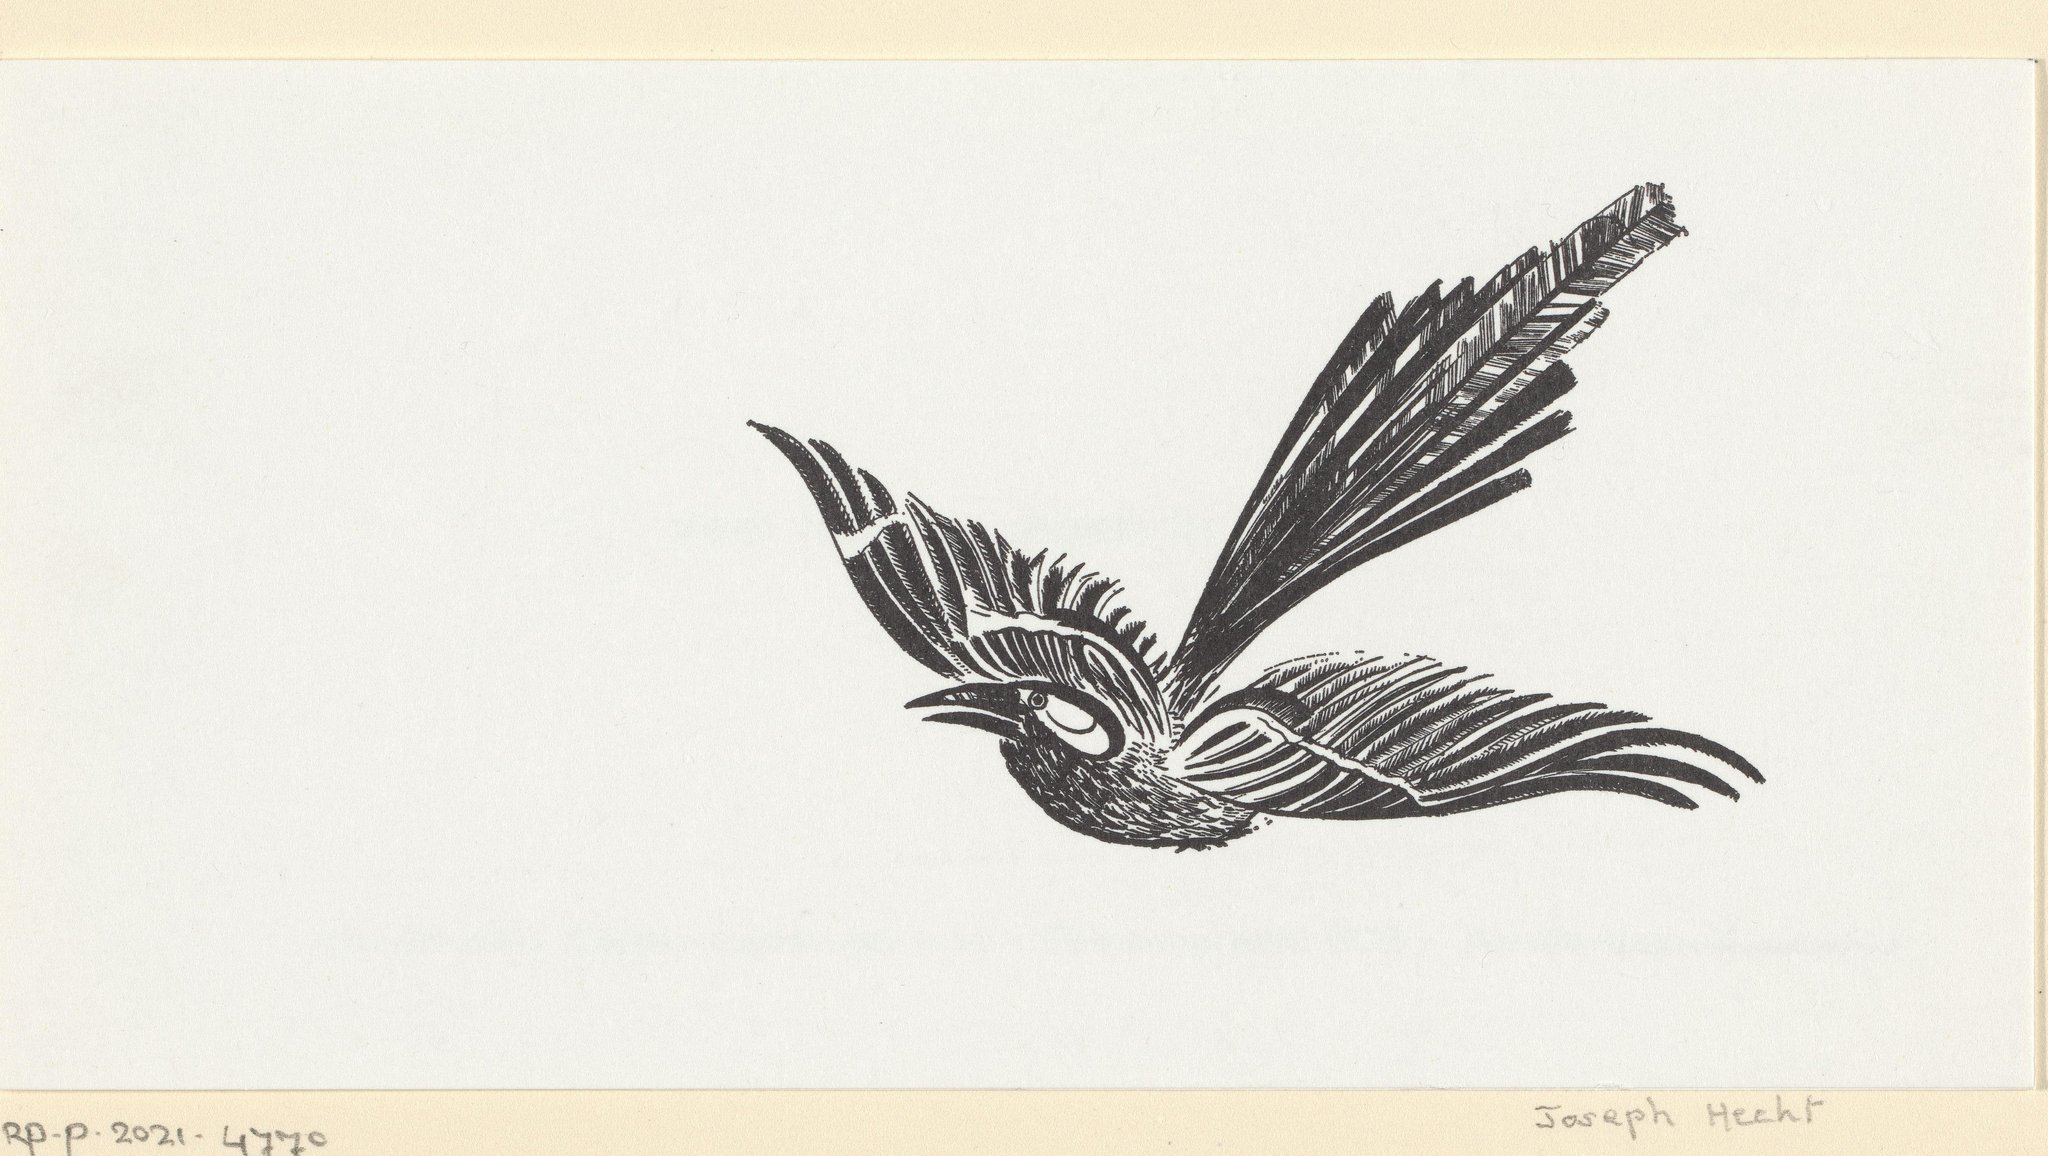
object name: new year card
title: Nieuwjaarswens voor 1972 van kunsthandel Santee Landweer n.v.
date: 1971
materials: paper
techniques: printing block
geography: amsterdam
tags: birds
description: Bij gebrek aan gegevens over de vervaardiger is voor de bepaling van de rechten van dit object gebruik gemaakt van de vervaardigingsdatum.